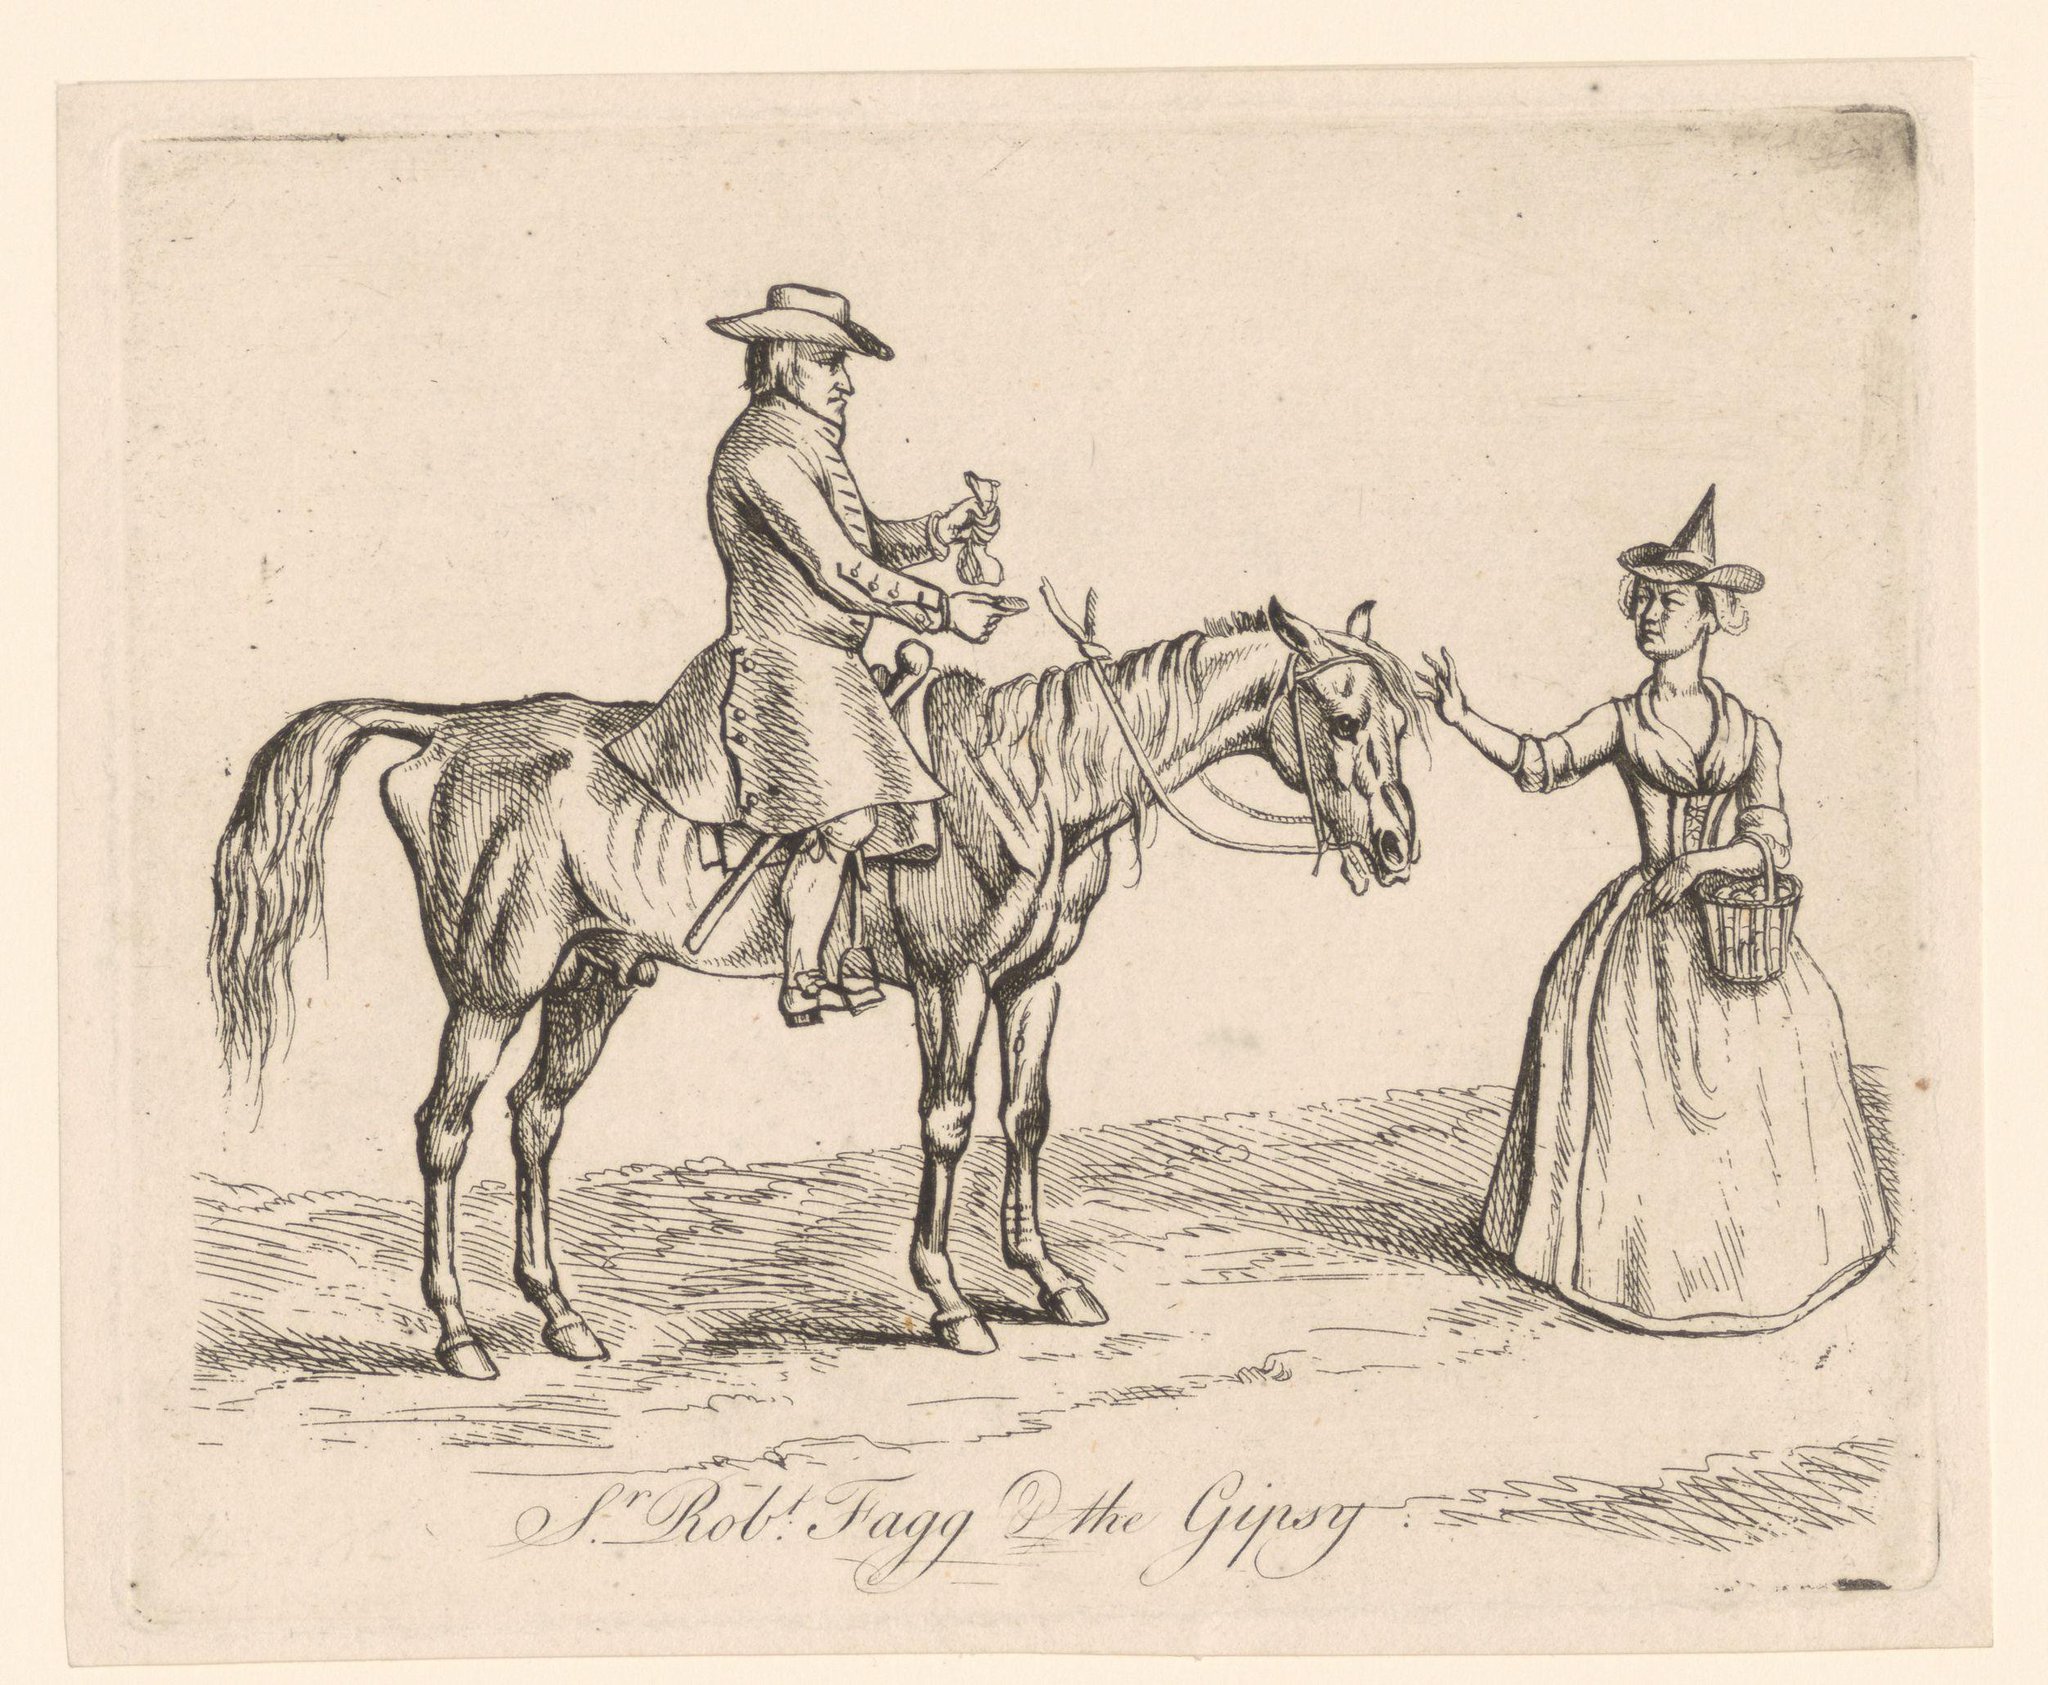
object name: print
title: Robert Fagge te paard koopt eieren bij een vrouw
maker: william hogarth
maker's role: draughtsman, painter, print maker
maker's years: 1697-1764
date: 1707-1764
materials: paper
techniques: etching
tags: riding a horse, ass, or mule; rider, horseman, buying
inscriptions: collector's mark: Lugt 2228